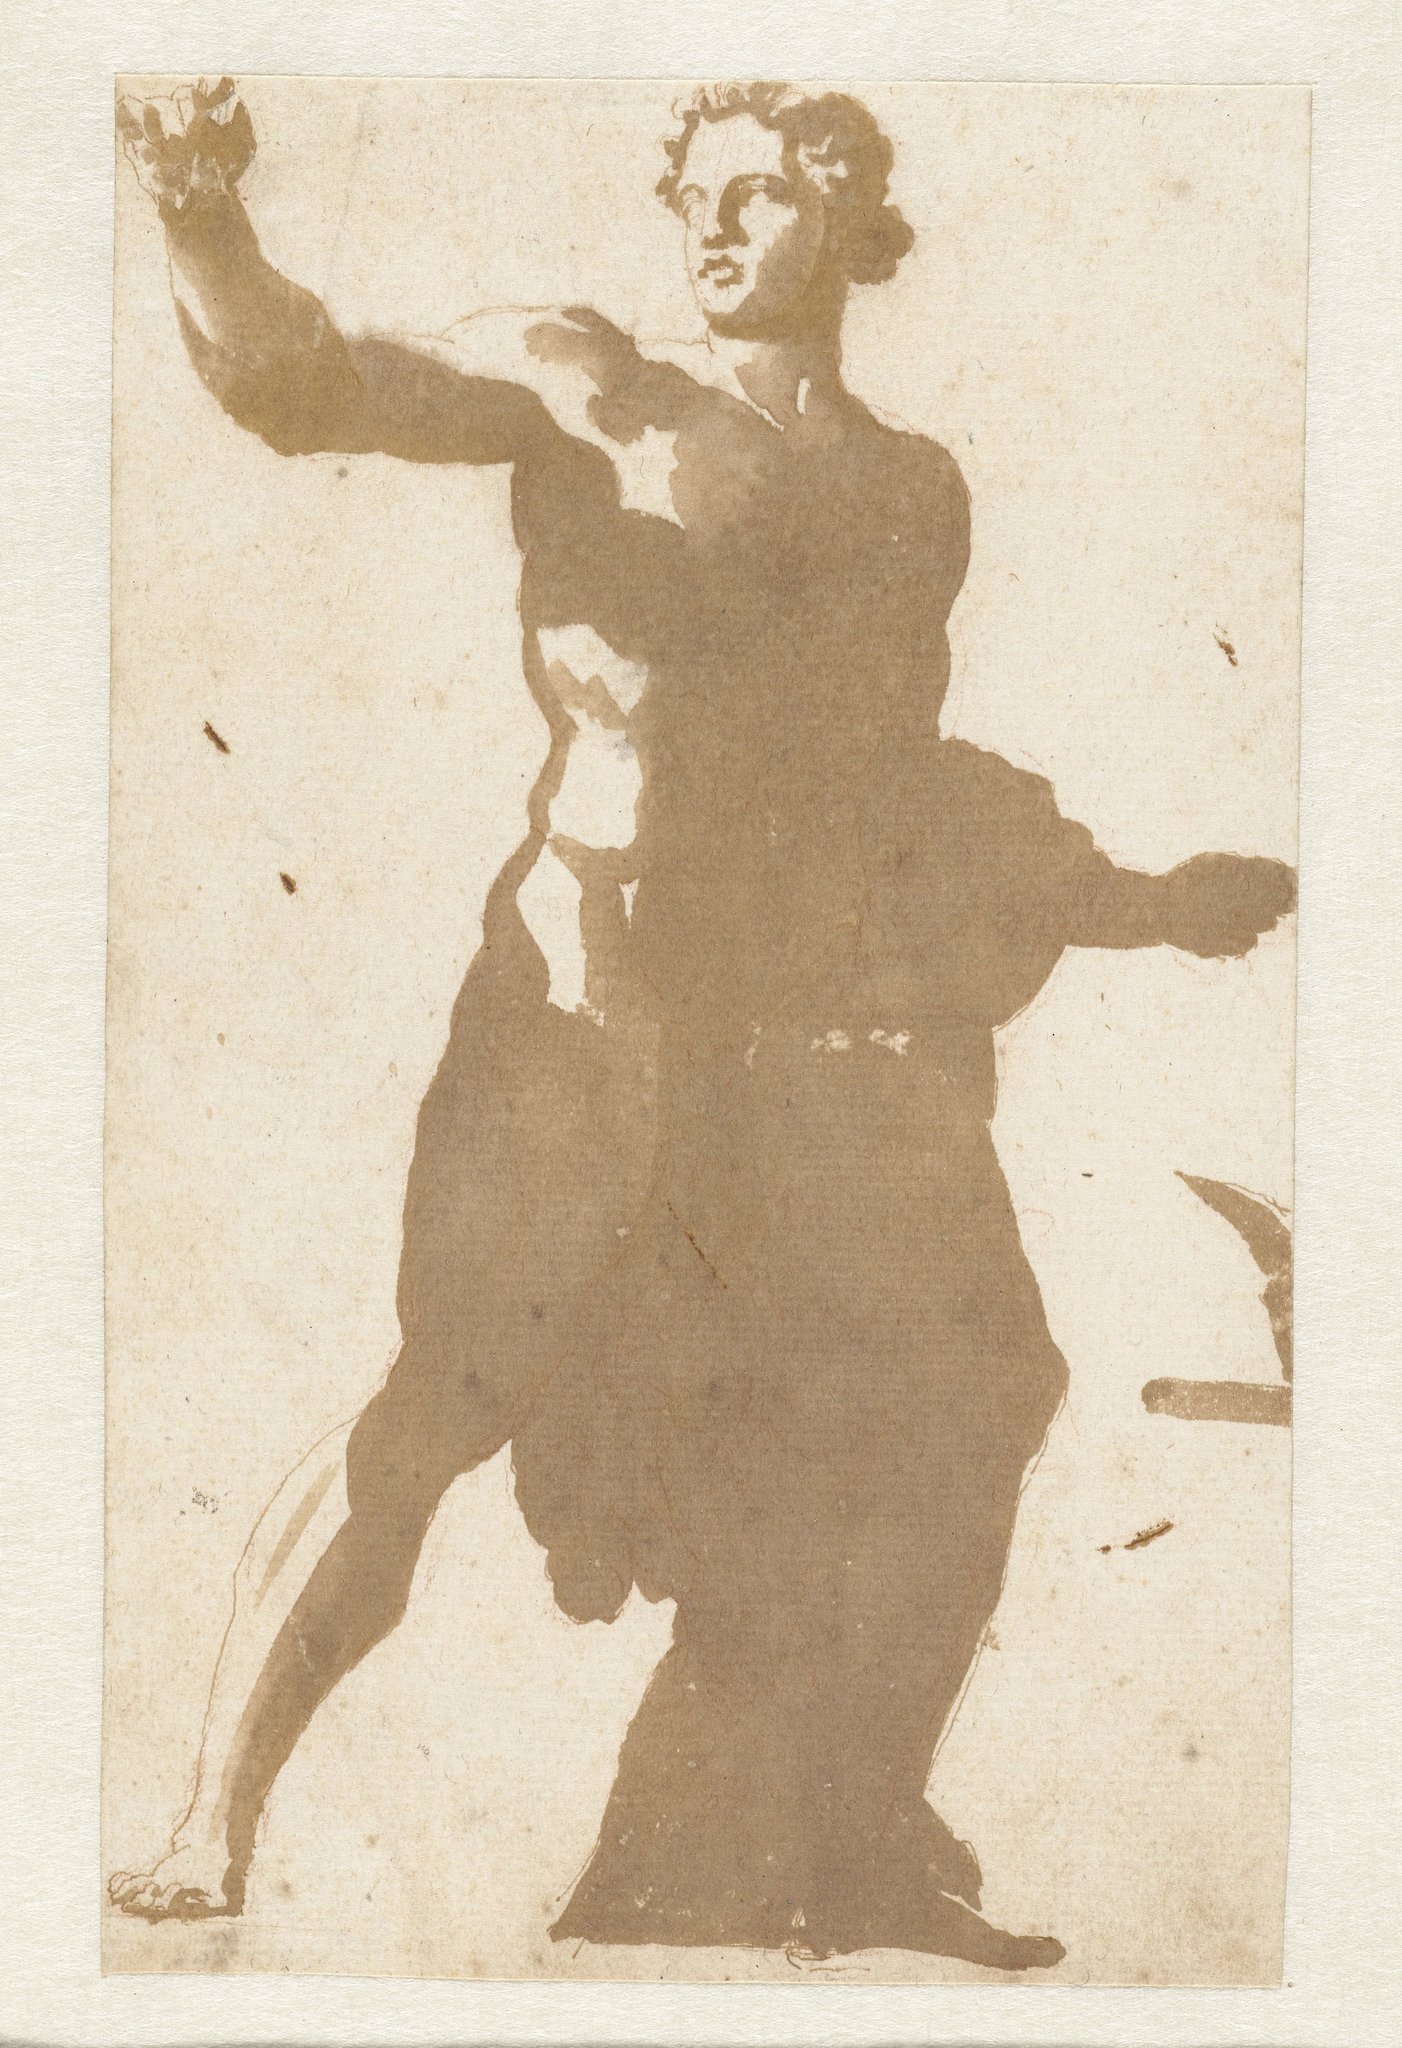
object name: drawing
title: Een van de dioscuren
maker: augustinus terwesten (i)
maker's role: draughtsman, painter, print maker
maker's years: 1649-1711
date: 1677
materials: chalk, ink, paper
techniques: brush, pen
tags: piece of sculpture, reproduction of a piece of sculpture, (story of) the dioscuri: castor (the horse-tamer) and pollux (the boxer)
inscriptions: date: ‘1677’